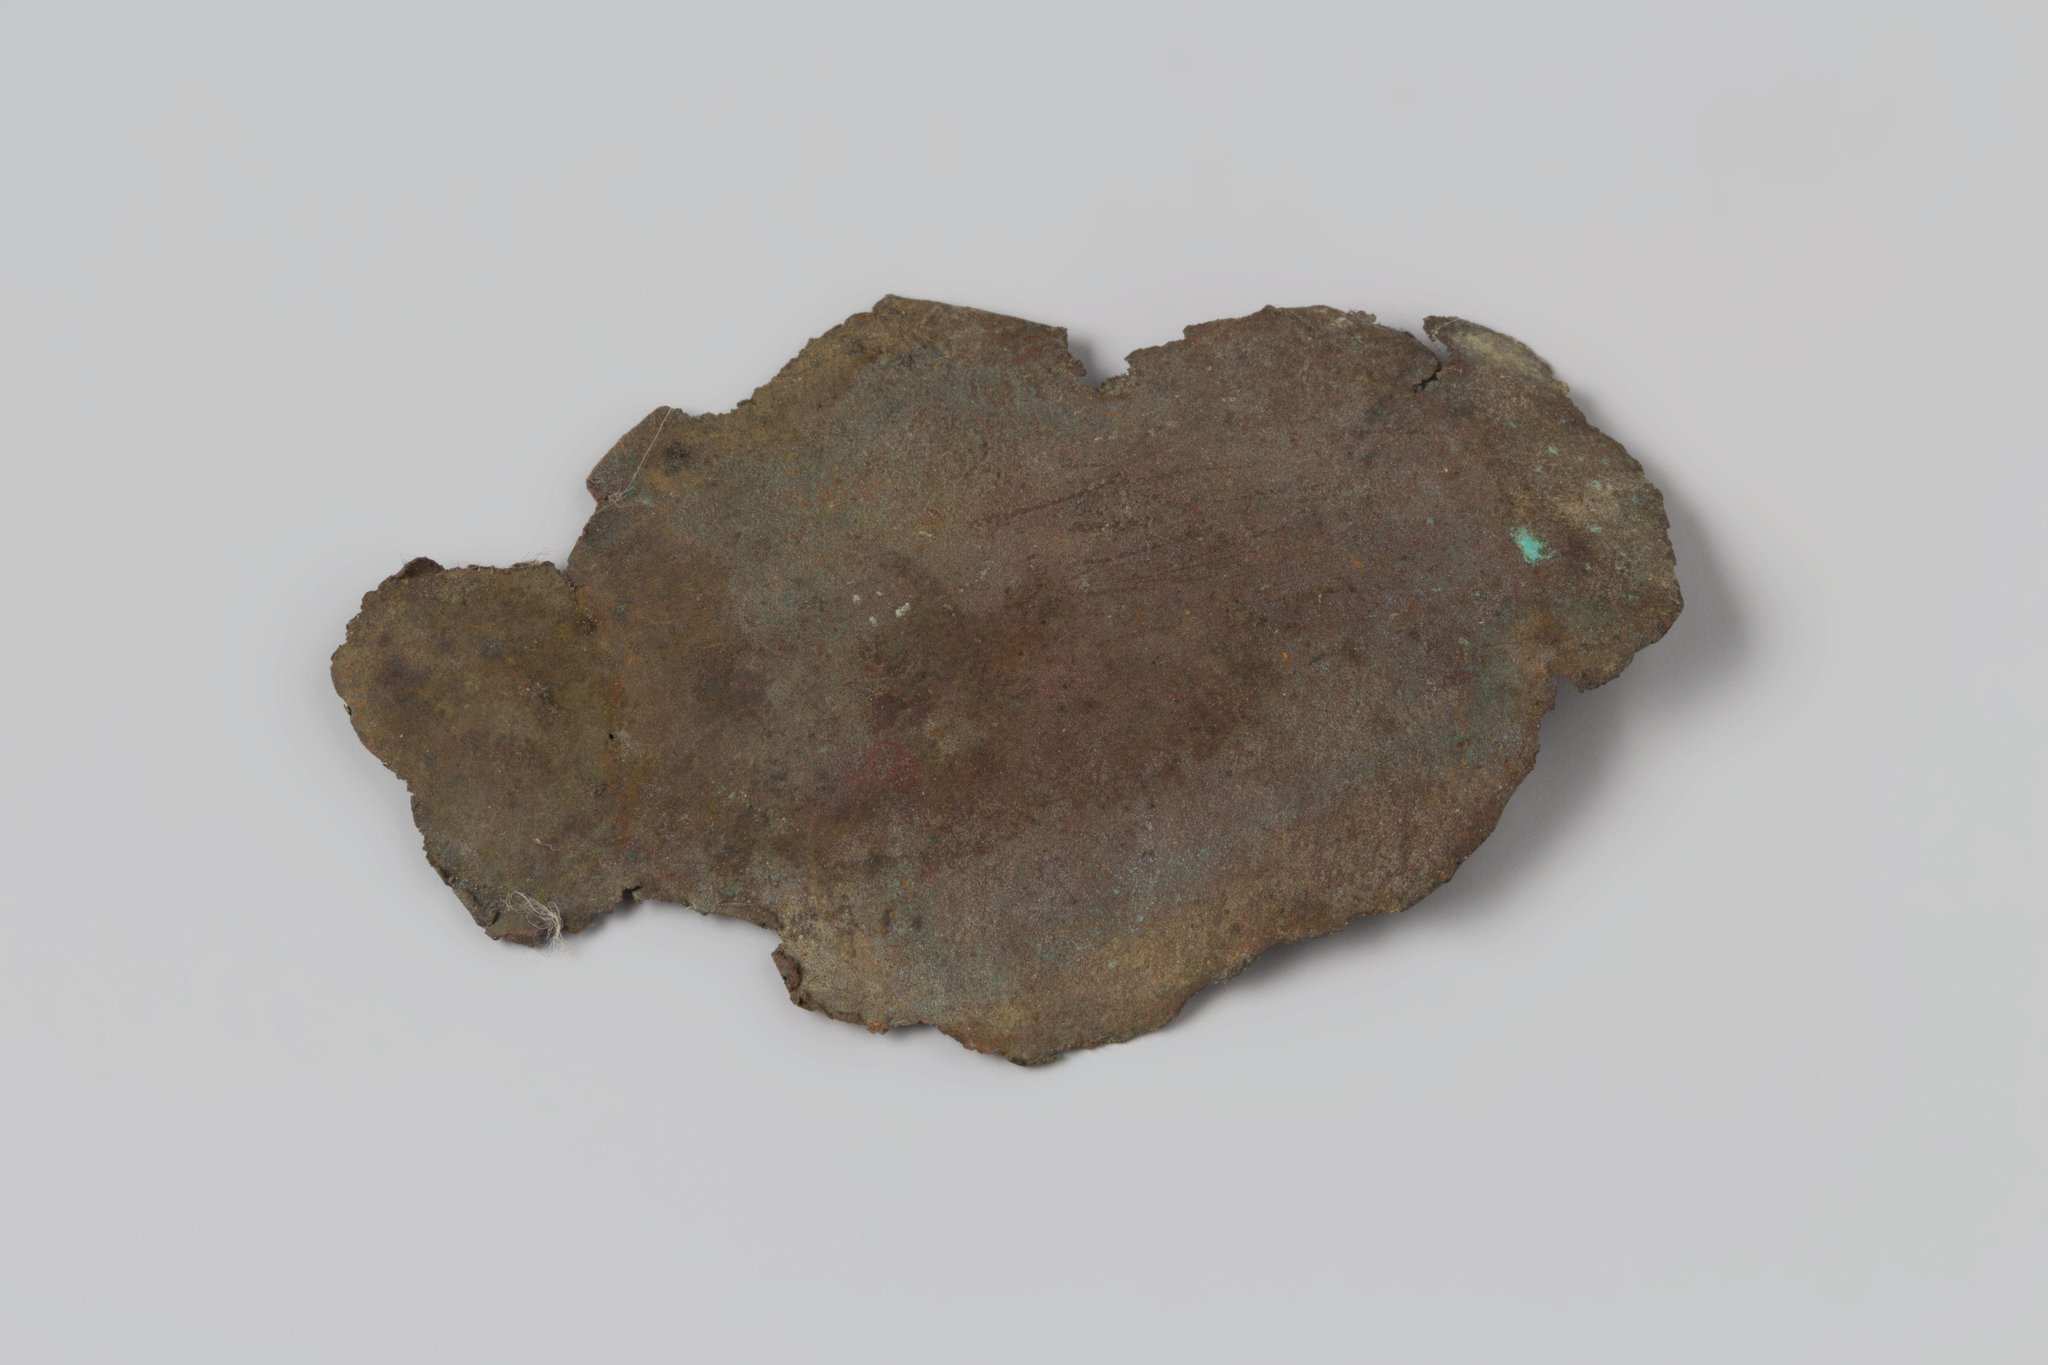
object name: scheepswrakvondst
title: Fragment van koper uit het wrak van de Oost-Indiëvaarder Hollandia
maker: Anonymous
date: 1700-1743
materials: copper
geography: netherlands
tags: verenigde oostindische compagnie, hollandia (schip), annet